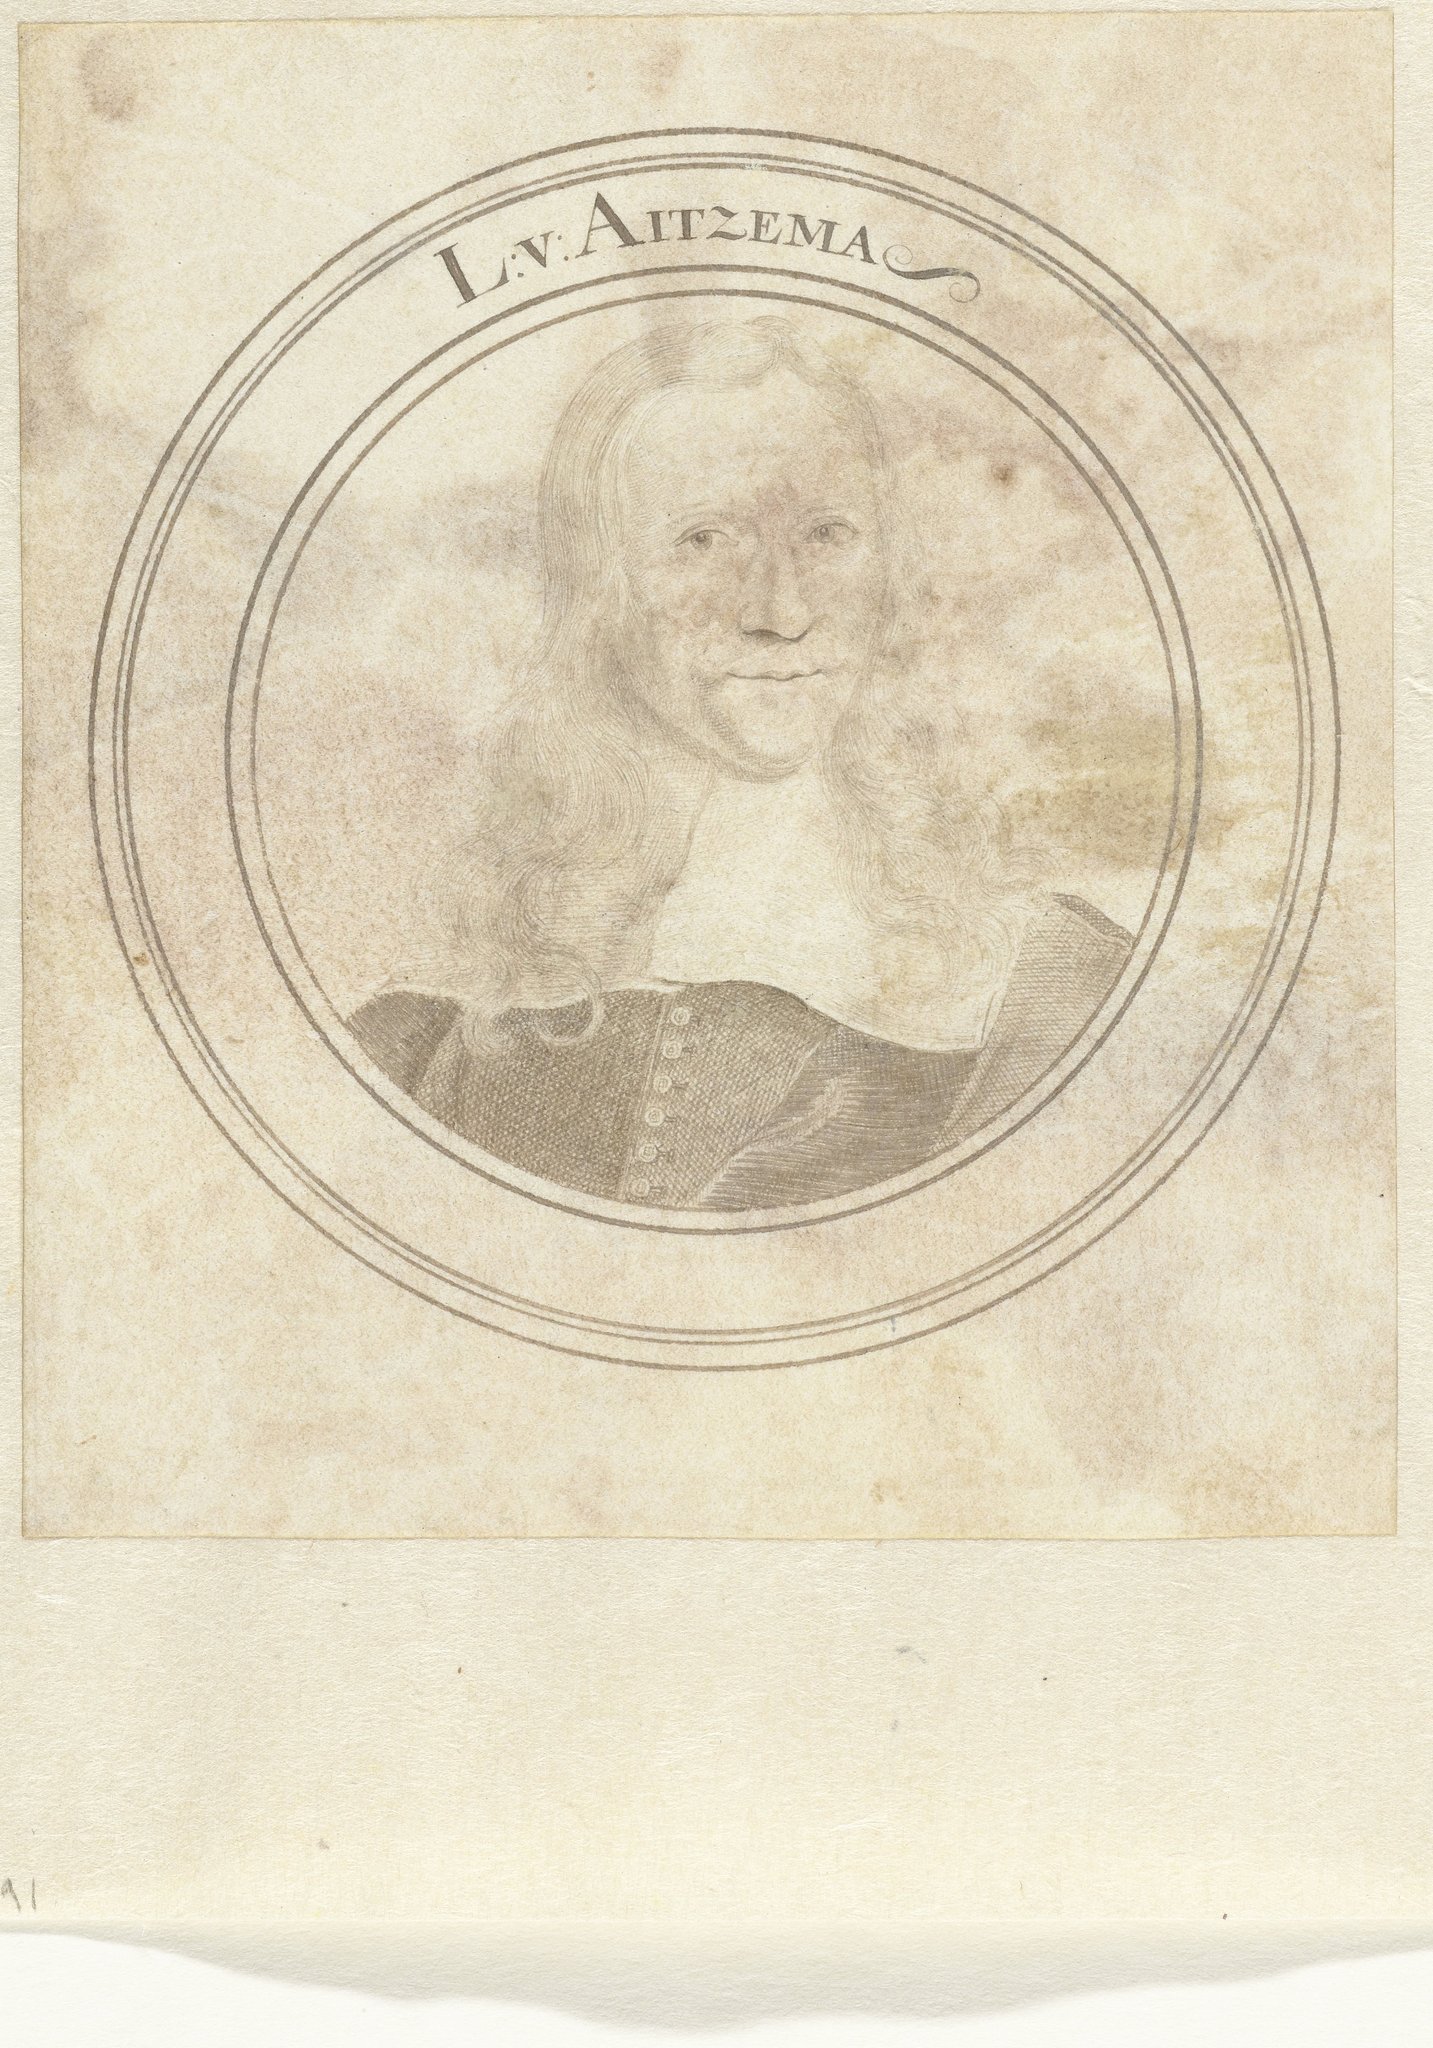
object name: drawing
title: Portret van Lieuwe van Aitzema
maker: john faber (i)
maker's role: draughtsman, print maker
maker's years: 1650-1721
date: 1660-1721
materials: ink, parchment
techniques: pen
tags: dokkum, lieuwe van aitzema